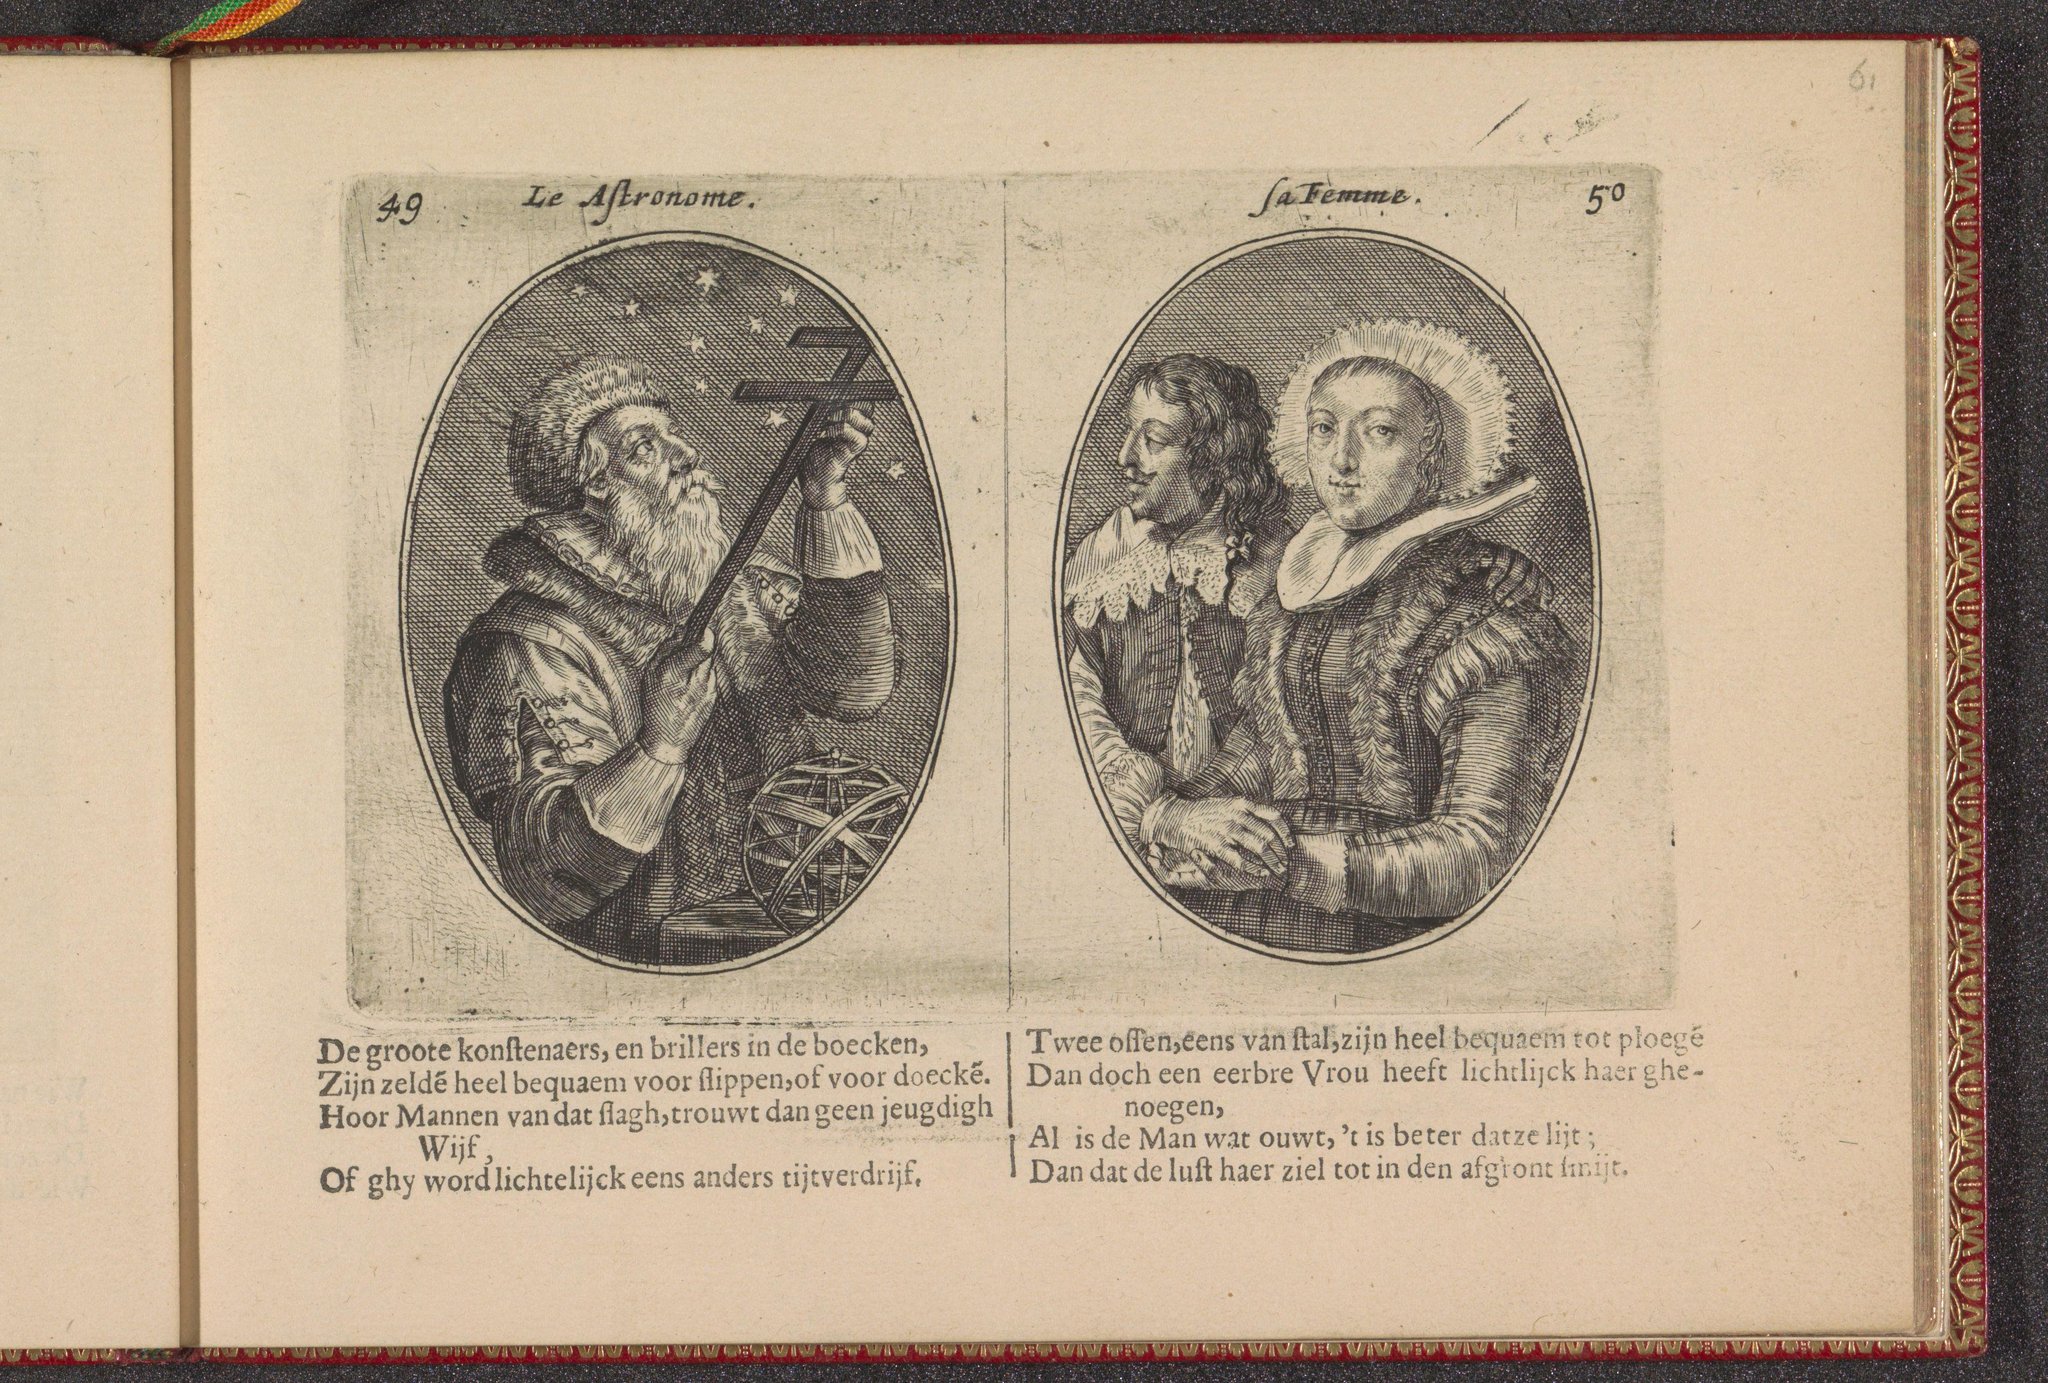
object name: print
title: Astronoom en zijn vrouw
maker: crispijn van de passe (ii)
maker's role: draughtsman, print maker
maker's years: 1594-1670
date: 1641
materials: paper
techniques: engraving, letterpress printing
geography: amsterdam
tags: female sex; woman, astronomical instruments, unequal couple, ill-matched couple, armillary sphere, skeleton celestial globe, adultery, couple of lovers, male sex; man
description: Twee voorstellingen op een albumblad. Links een astronoom met astrolabium en jakobsstaf. Rechts zijn jongere vrouw met een andere jongere man. Daaronder twee kwatrijnen in het Nederlands. De prent maakt deel uit van een album.